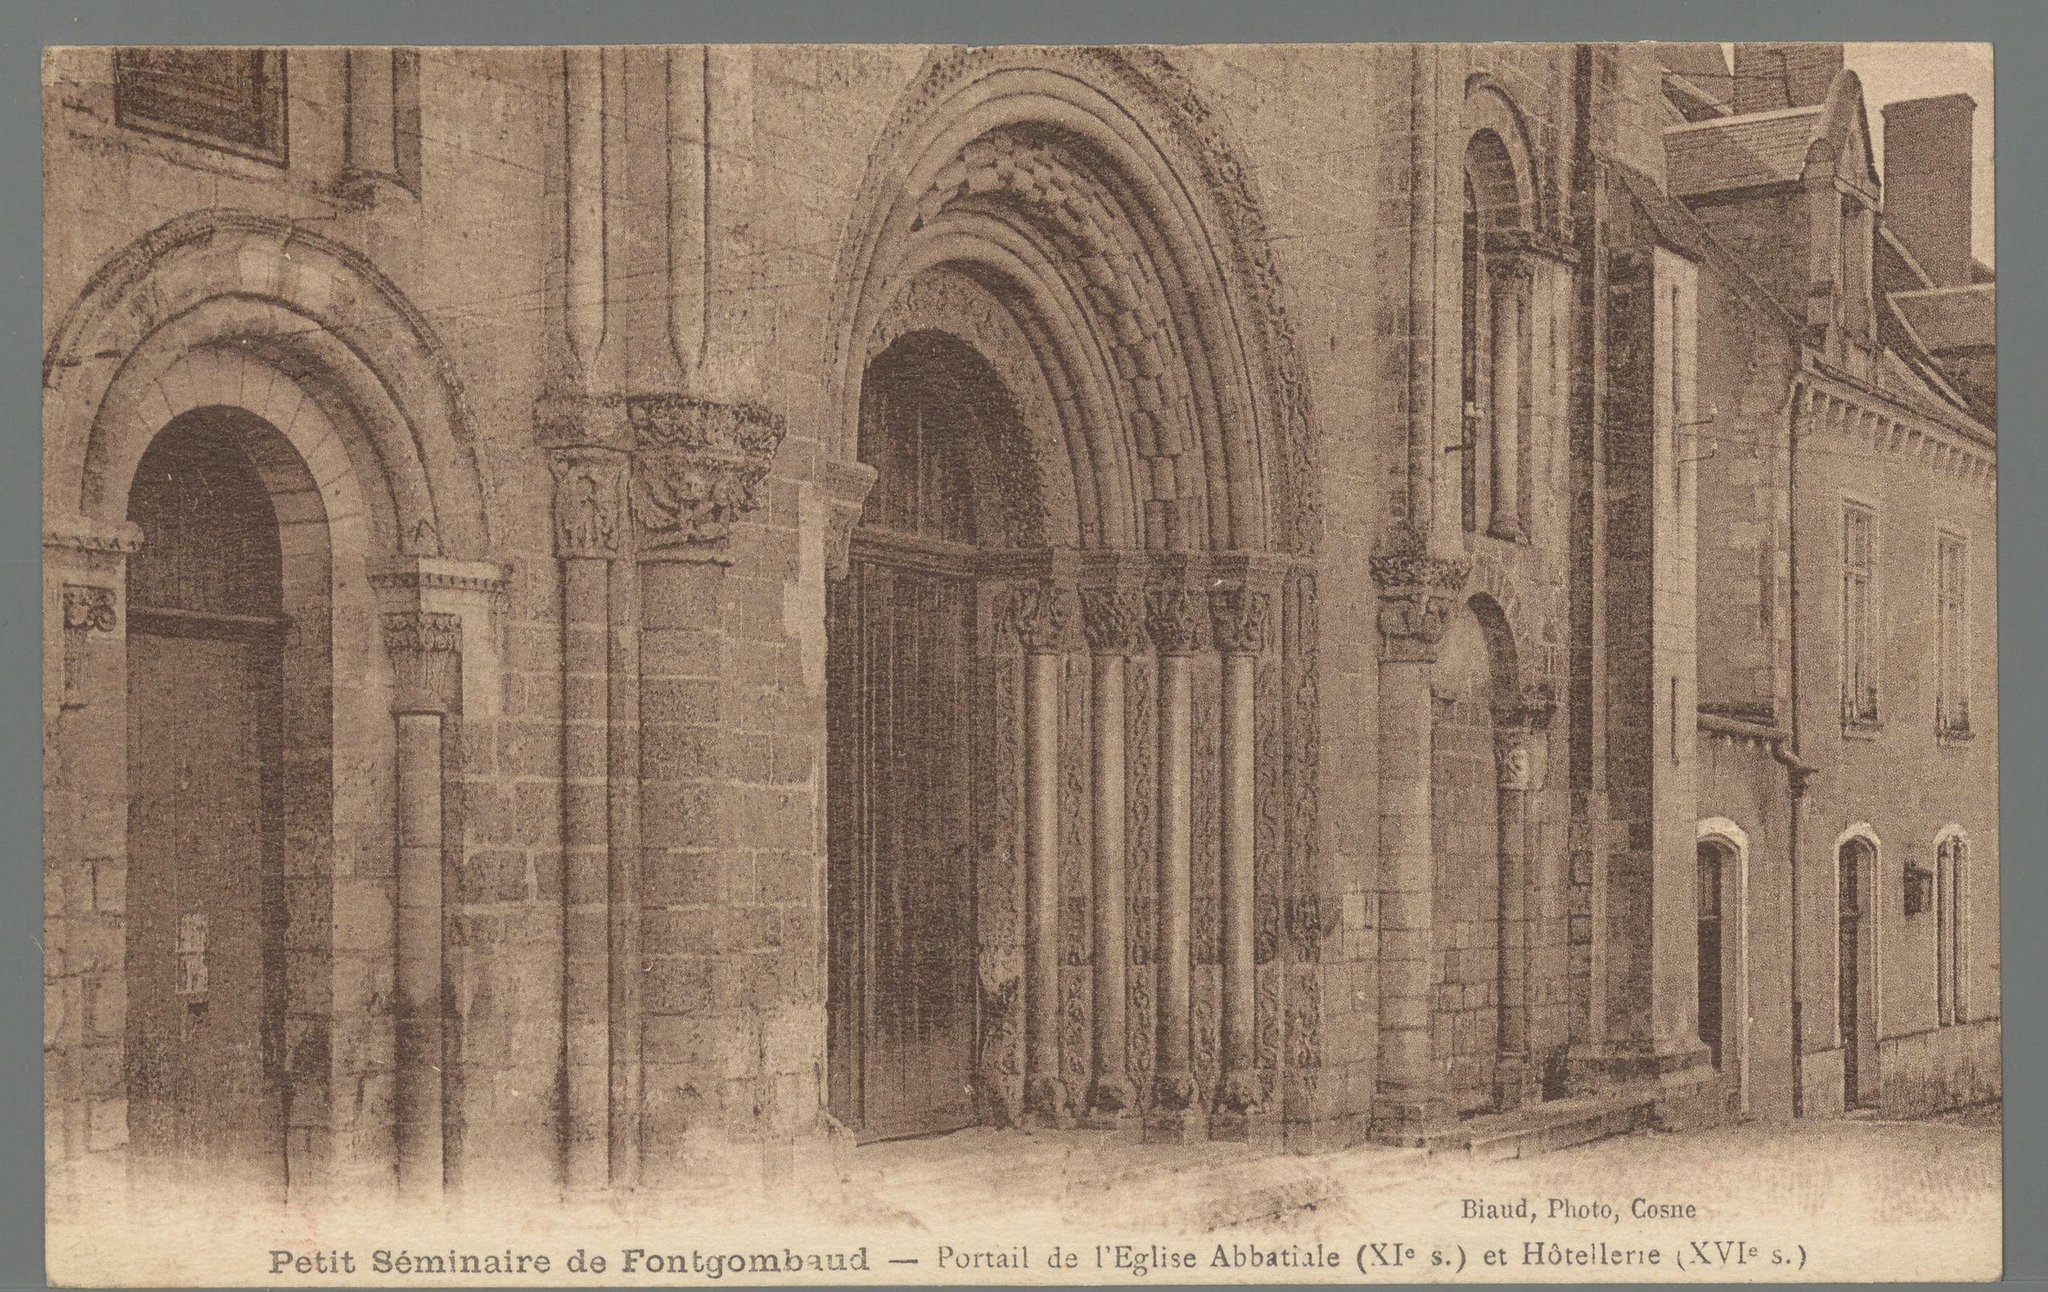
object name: ansichtkaart, prentbriefkaart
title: Petit Séminaire de Fontgombaud - Portail de l'Eglise Abbatiale (XIe s.) et Hôtellerie (XVIe s.)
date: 1903-1932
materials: cardboard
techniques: photograph, writing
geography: cosne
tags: abbey, monastery, convent ~ roman catholic church, church (exterior)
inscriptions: postage stamp